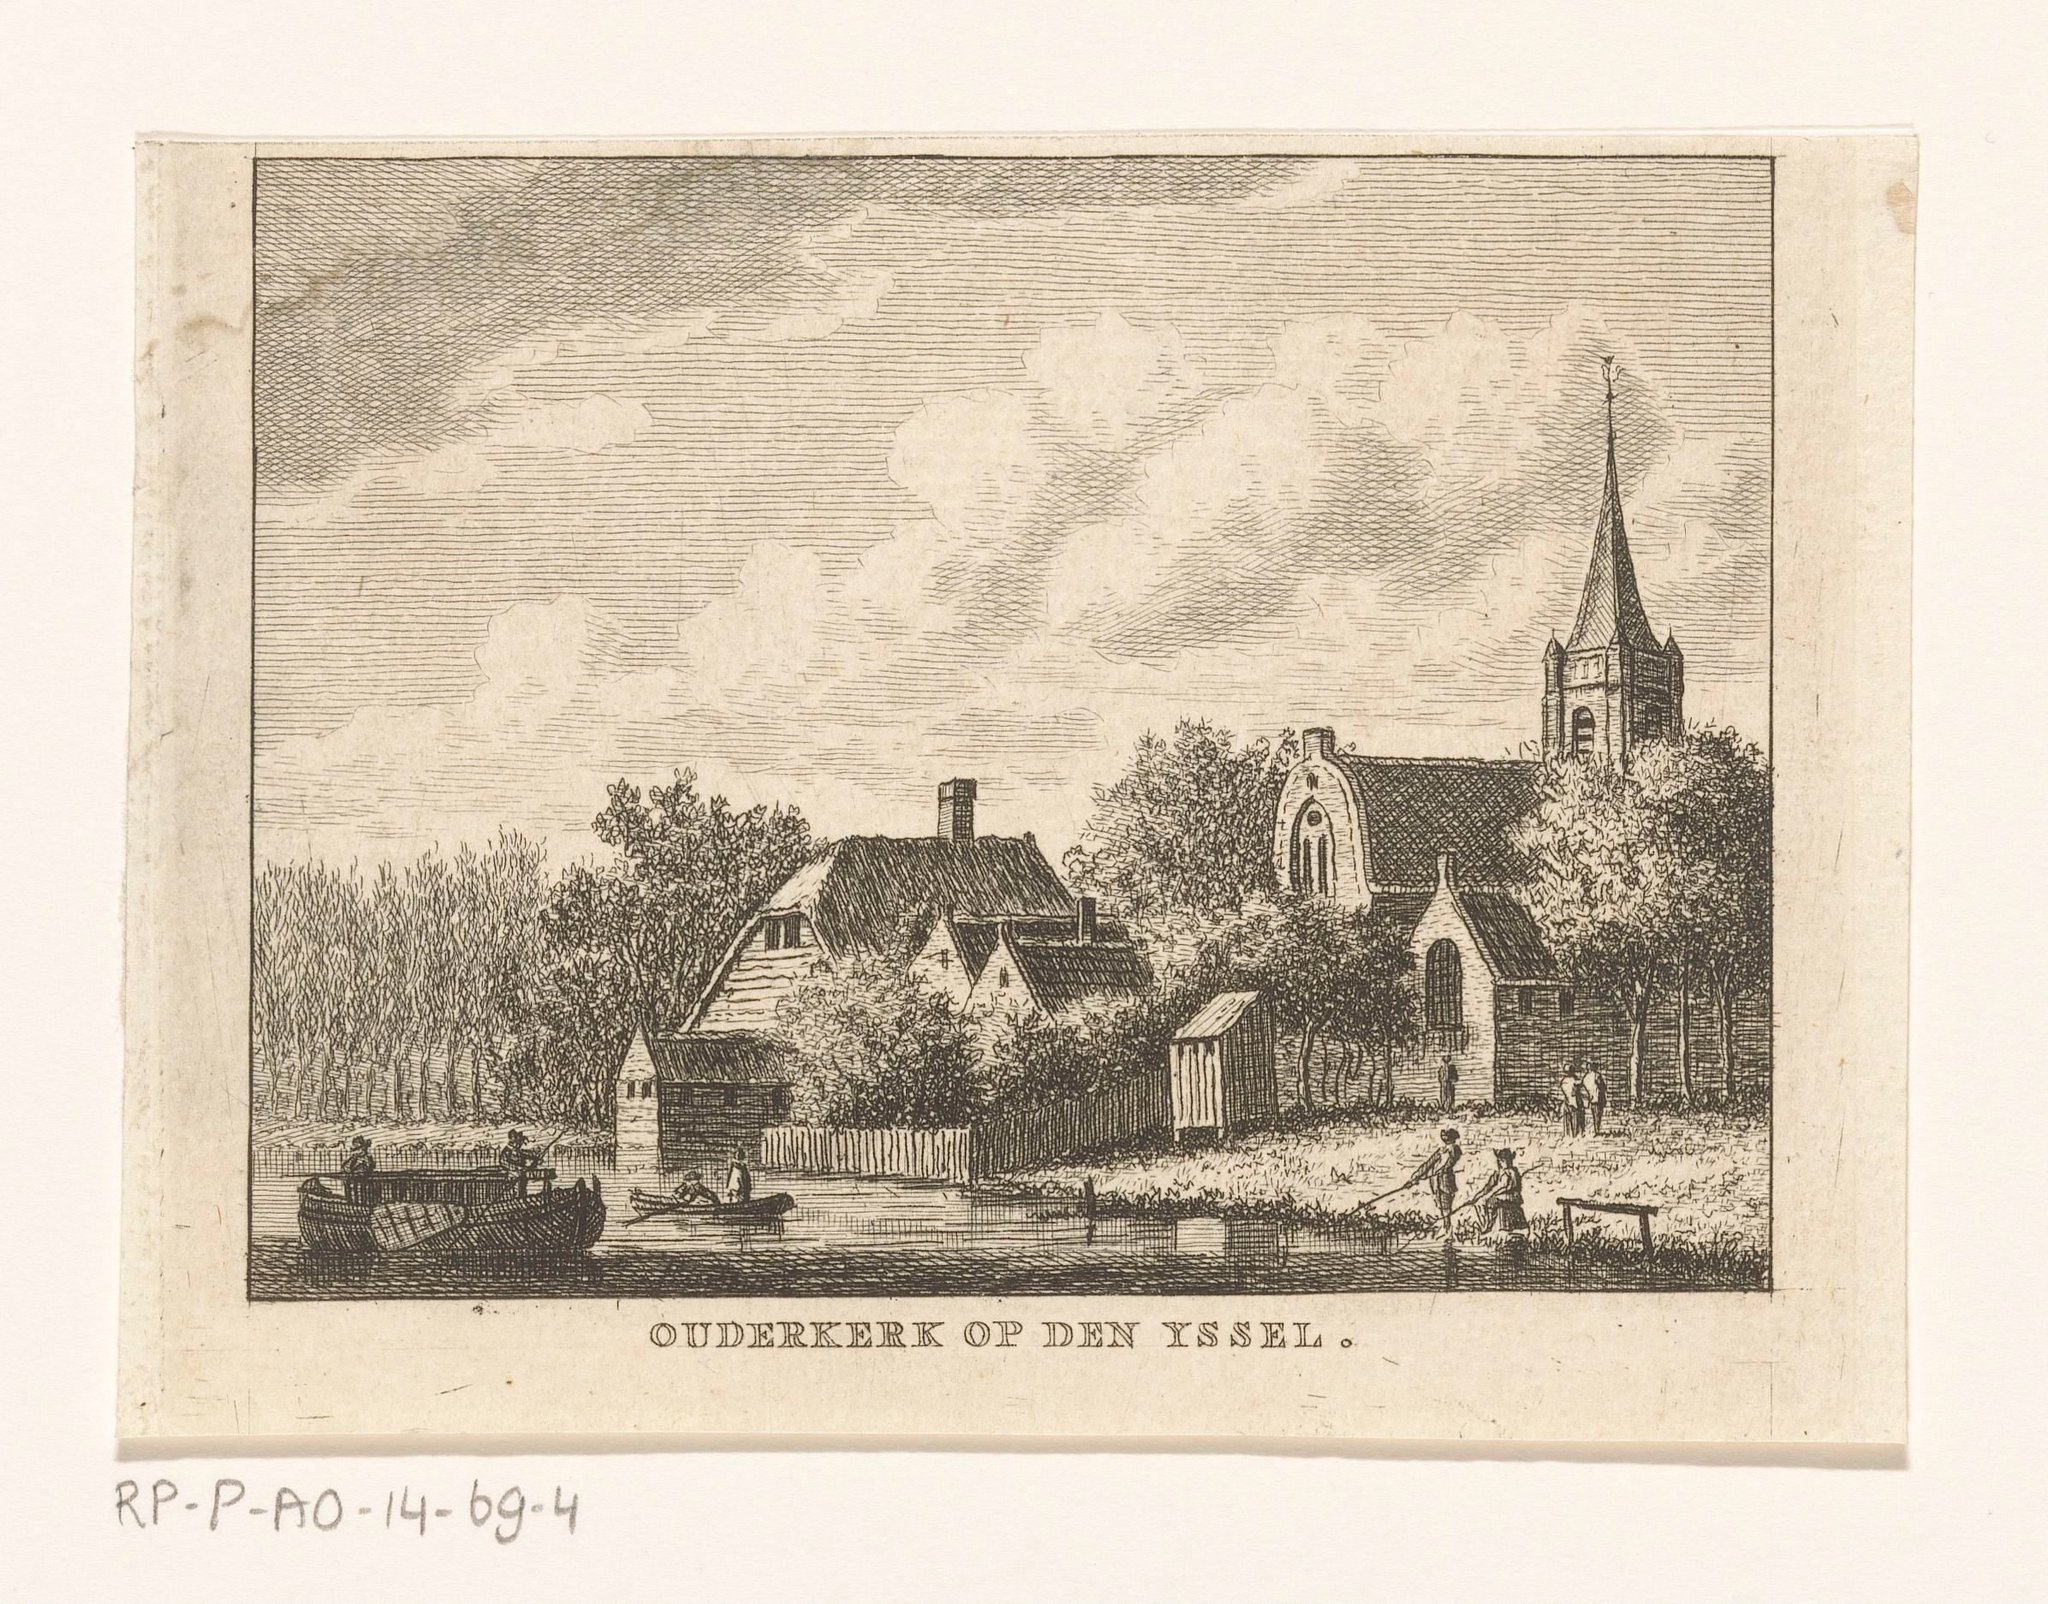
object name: print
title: Ouderkerk op den Yssel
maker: carel frederik bendorp (i)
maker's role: print maker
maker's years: 1736-1814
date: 1786-1792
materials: paper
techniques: engraving, etching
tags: prospect of village, silhouette of village, church (exterior), rowing-boat, canoe, etc., fisherman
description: Prent uit: Vaderlandsche gezichten, of afbeeldingen van den tegenwoordigen staat der Vereenigde Nederlanden (…). Amsterdam: Hendrik Gartman, Willem Vermandel en Jan Willem Smit, 1786-1792. Uitgegeven in afleveringen met ieder een eigen bifolium en inhoudsopgave. Alle prenten in deze publicatie zijn gegraveerd door Carel Frederik Bendorp (I) en, in de meeste gevallen, gebaseerd op tekeningen van Jan Bulthuis.